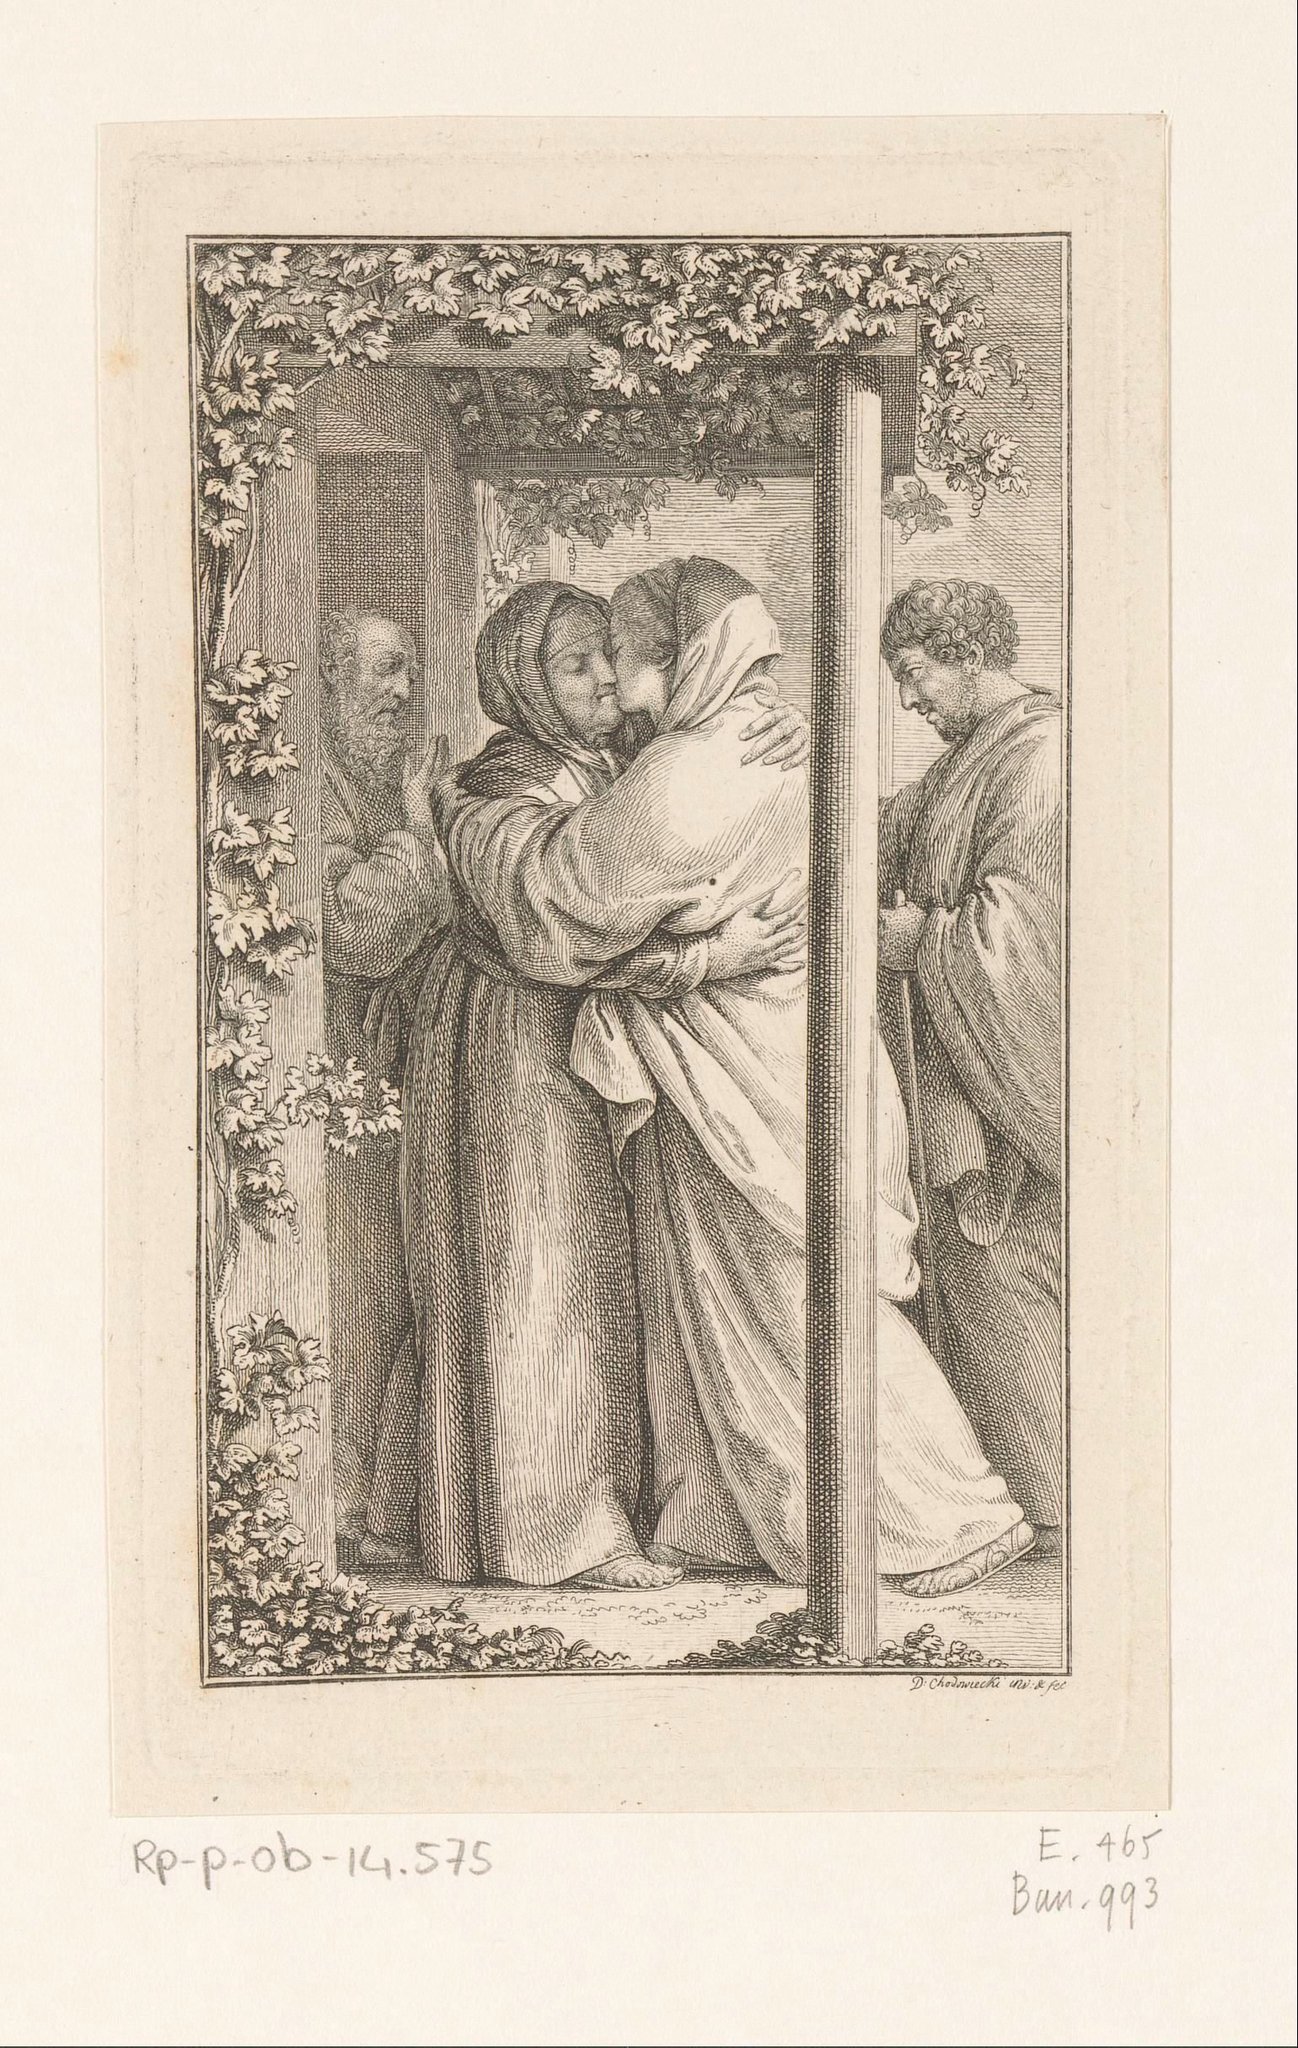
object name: print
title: Visitatie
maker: daniel nikolaus chodowiecki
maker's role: draughtsman, print maker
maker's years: 1726-1801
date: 1783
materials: paper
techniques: etching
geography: berlin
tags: johann caspar lavater, vine, visitation (possibly joseph and/or zacharias present) (luke 1:39-56)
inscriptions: collector's mark: Lugt 2228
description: Prent gebruikt voor: Lavater, Johann Caspar. Jesus Messias, Oder die Evangelien und die Apostelgeschichte in Gesängen. 4 dln. Winterthur: s.n., 1783, dl. 1.